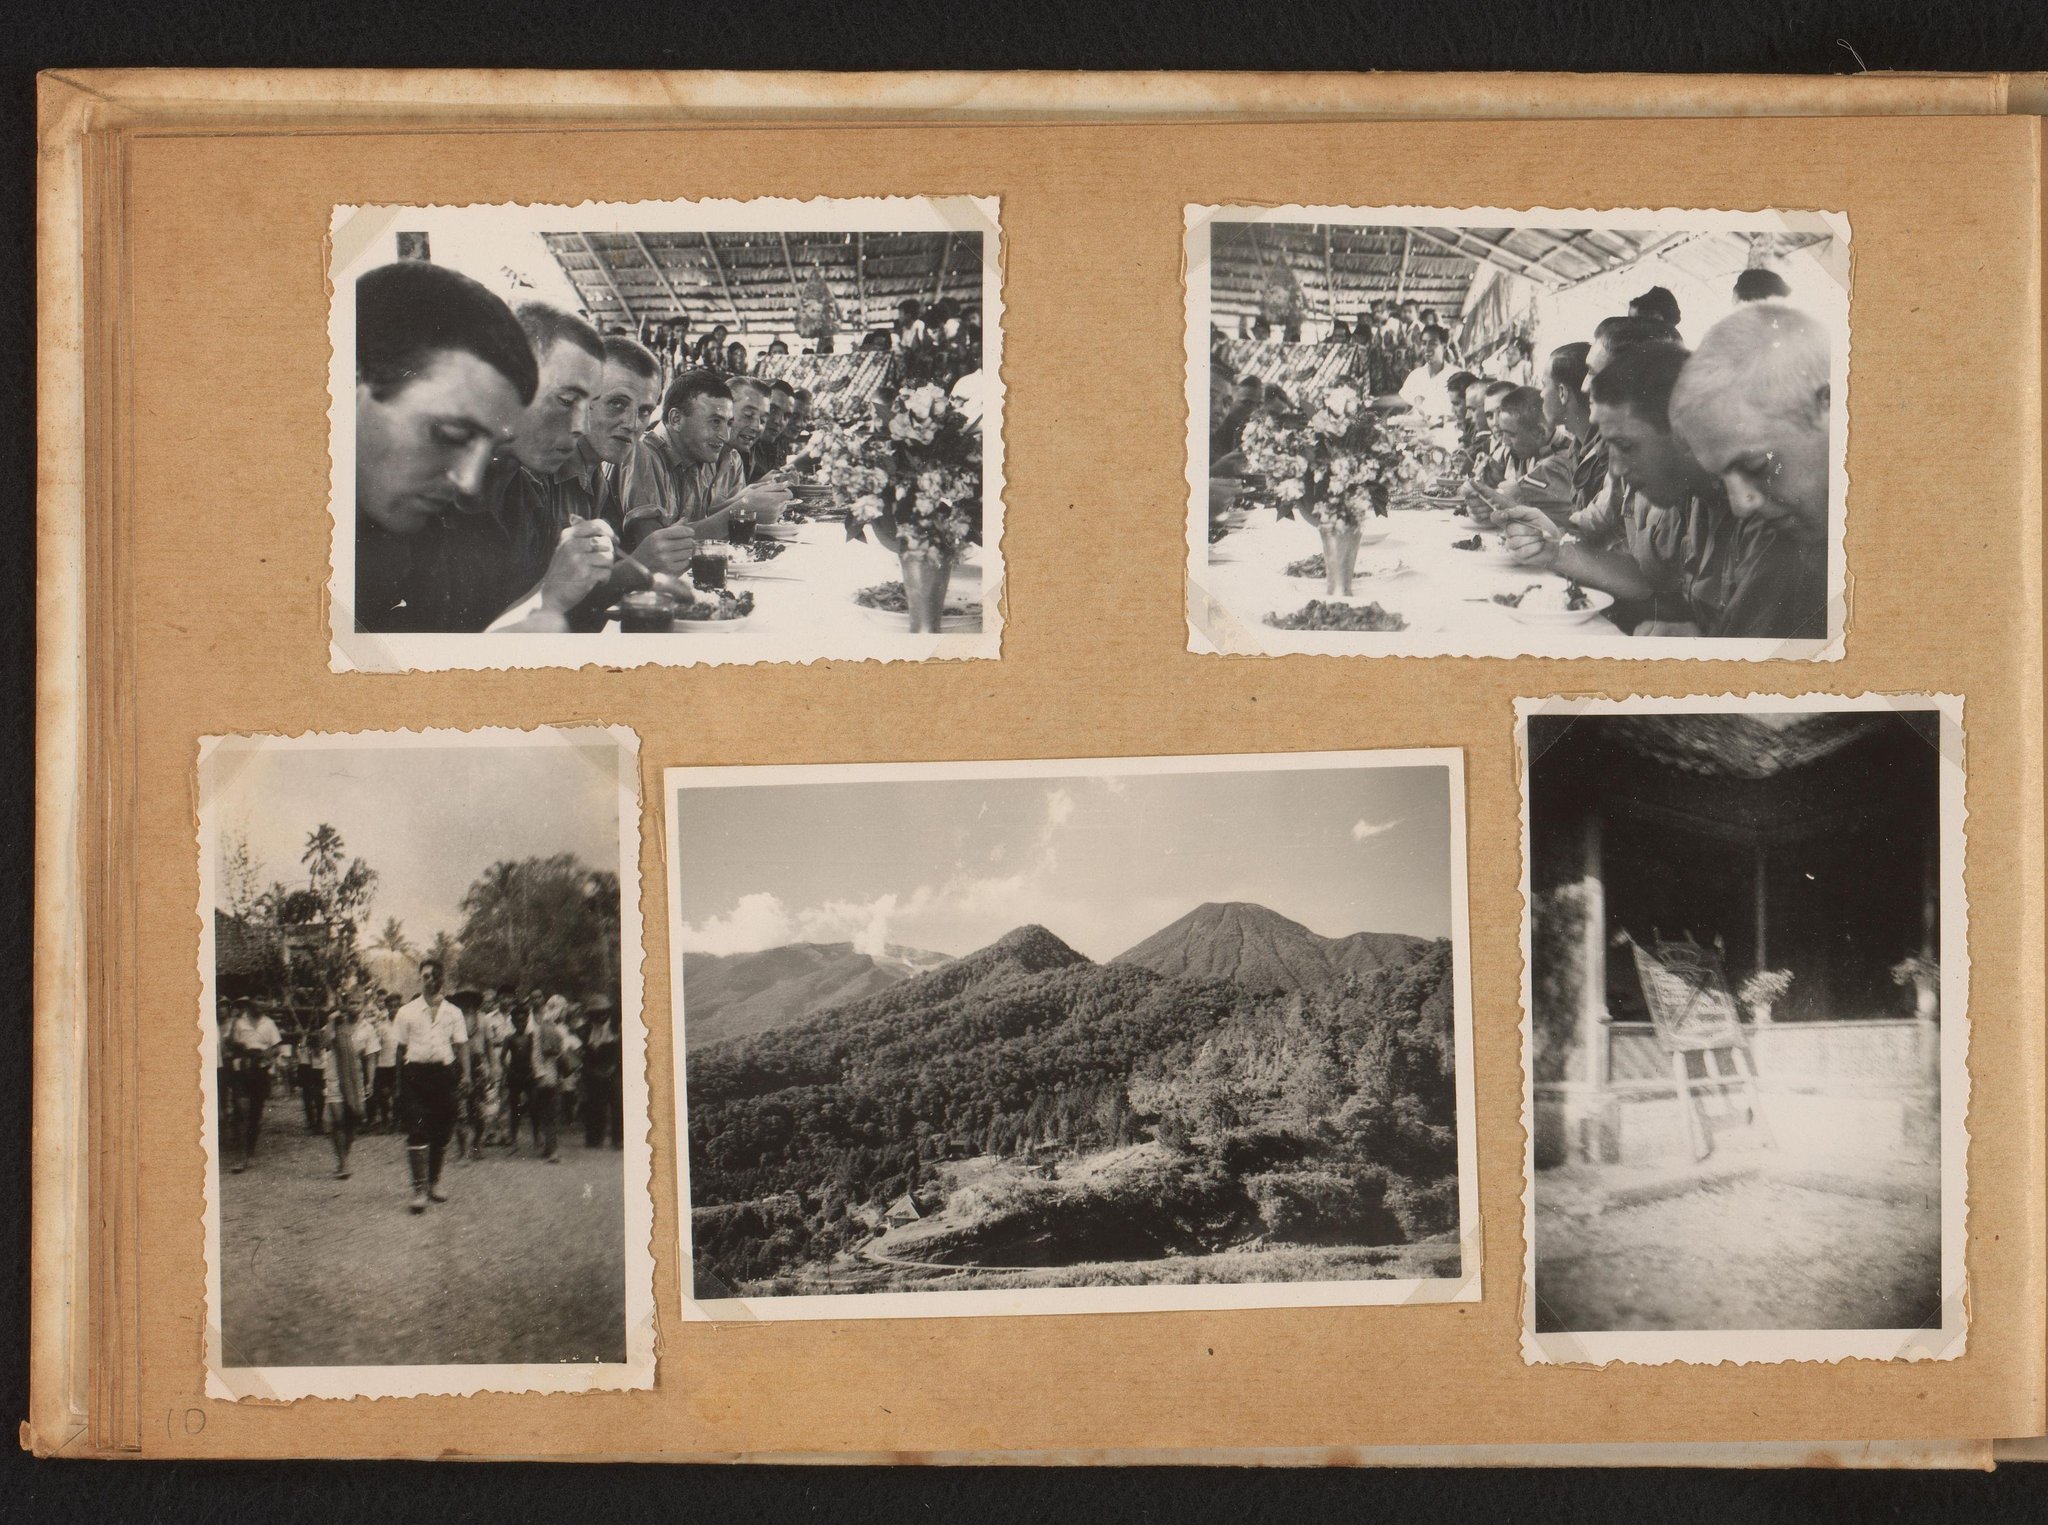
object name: photograph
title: Maaltijd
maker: Anonymous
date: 1948-1949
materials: paper, photographic support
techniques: gelatin silver print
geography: dutch east indies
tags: the company, the unit, the troop ~ military service, canteen ~ the soldier off duty, dutch east indies, the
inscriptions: inscription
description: Albumblad met vijf foto's van Nederlandse militairen etend aan lange tafels, landschappen en tafereel in een dorp. Onderdeel van het fotoalbum 'Ter herinnering aan mijn diensttijd overzee' 1948-1949.